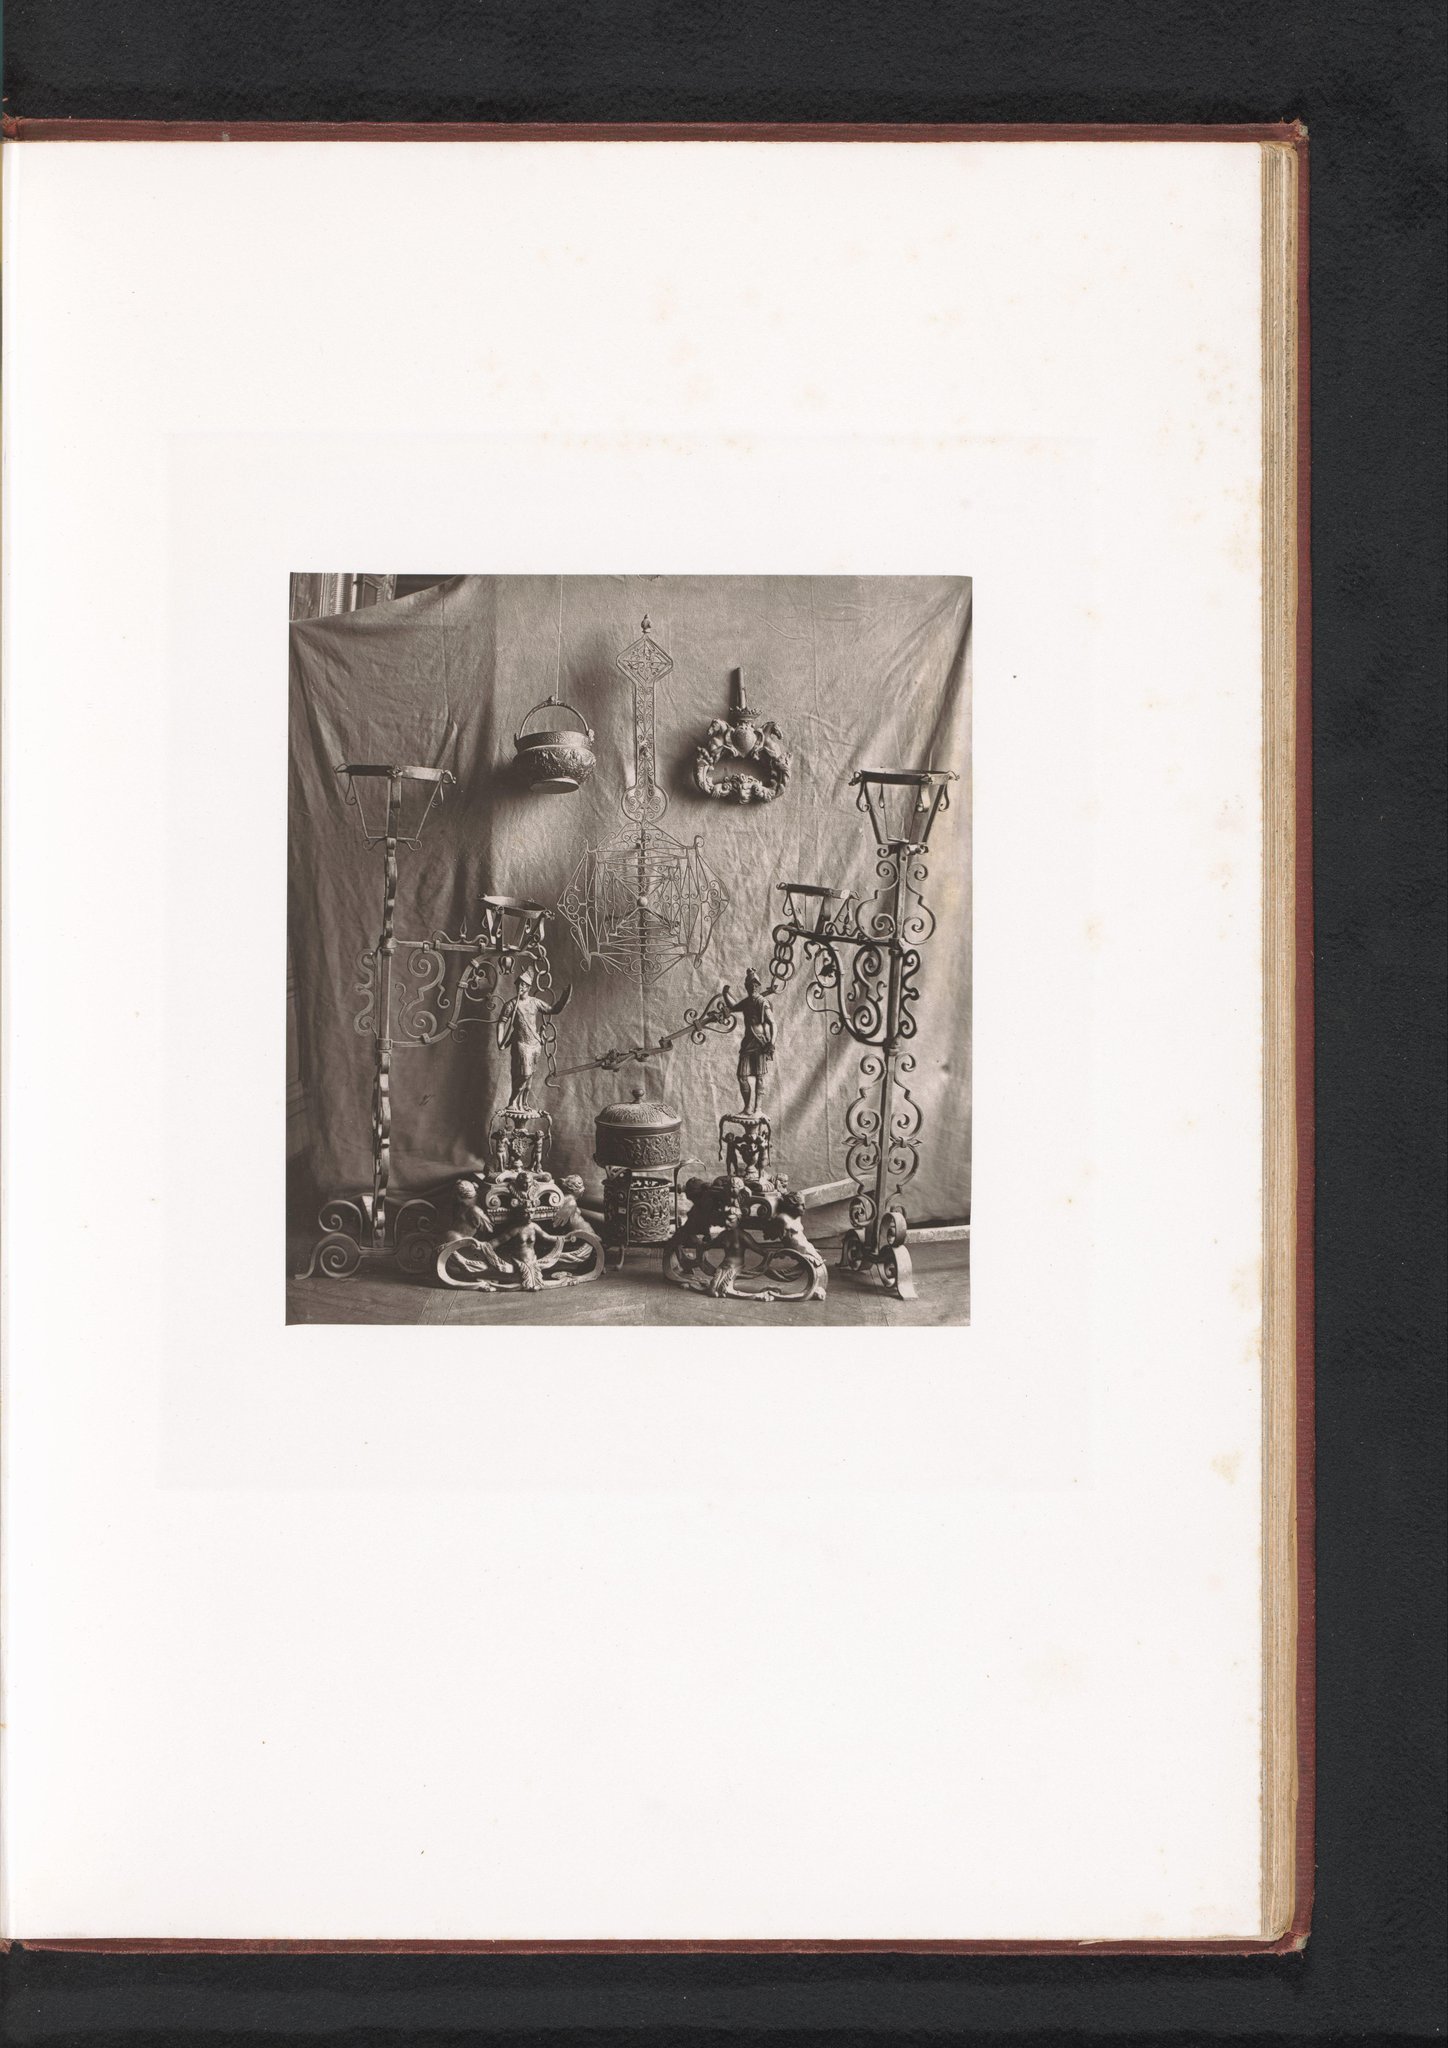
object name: page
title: Diverse objecten, opgesteld tijdens de Exposition Rétrospective van 1873 in Tours, Frankrijk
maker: gabriel blaise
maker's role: printer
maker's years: 1827-1897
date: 1873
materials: paper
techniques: woodburytype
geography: tours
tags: temporary exhibition, 'salon'